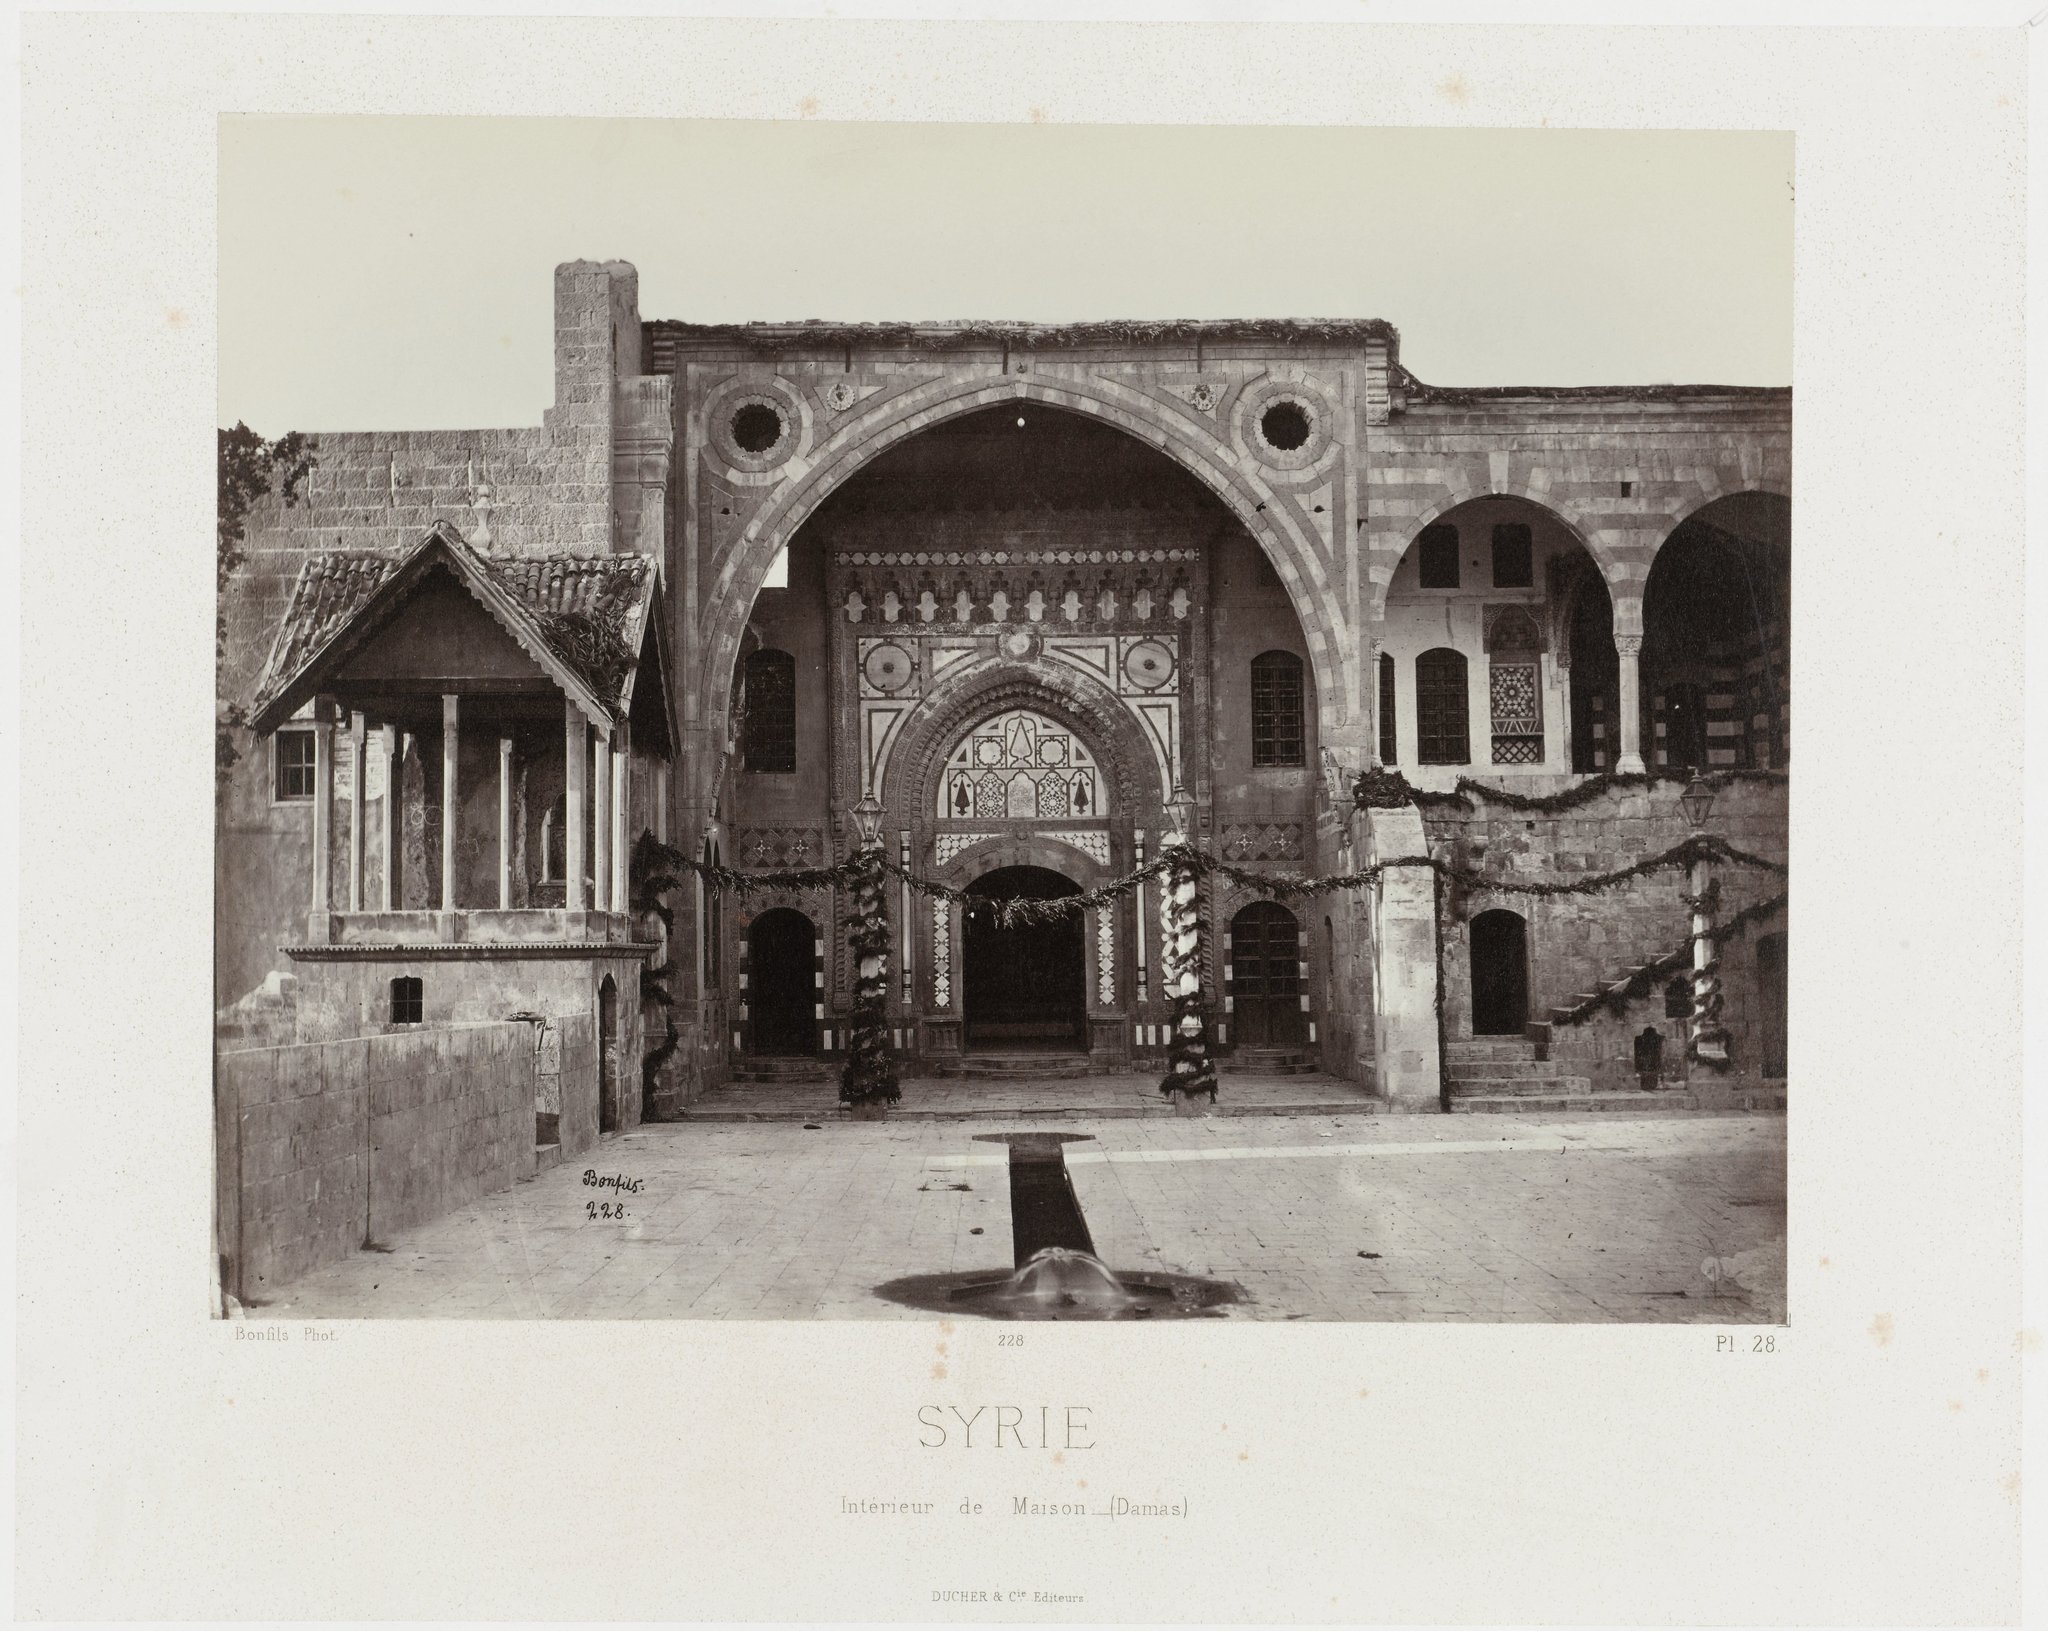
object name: photograph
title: Interieur van een woonhuis (Syrie/Intérieur de Maison - Damas)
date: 1872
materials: cardboard, paper, photographic support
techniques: albumen print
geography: syria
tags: syrië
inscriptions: signature: ‘Bonfils phot’, number: ‘Bonfils 228’, stamp: ‘Rijksschool voor Kunstnijverheid’, number: ‘Pl.28’, title, number: ‘228’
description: Syrie/Intérieur de Maison - Damas) Pl. 28.